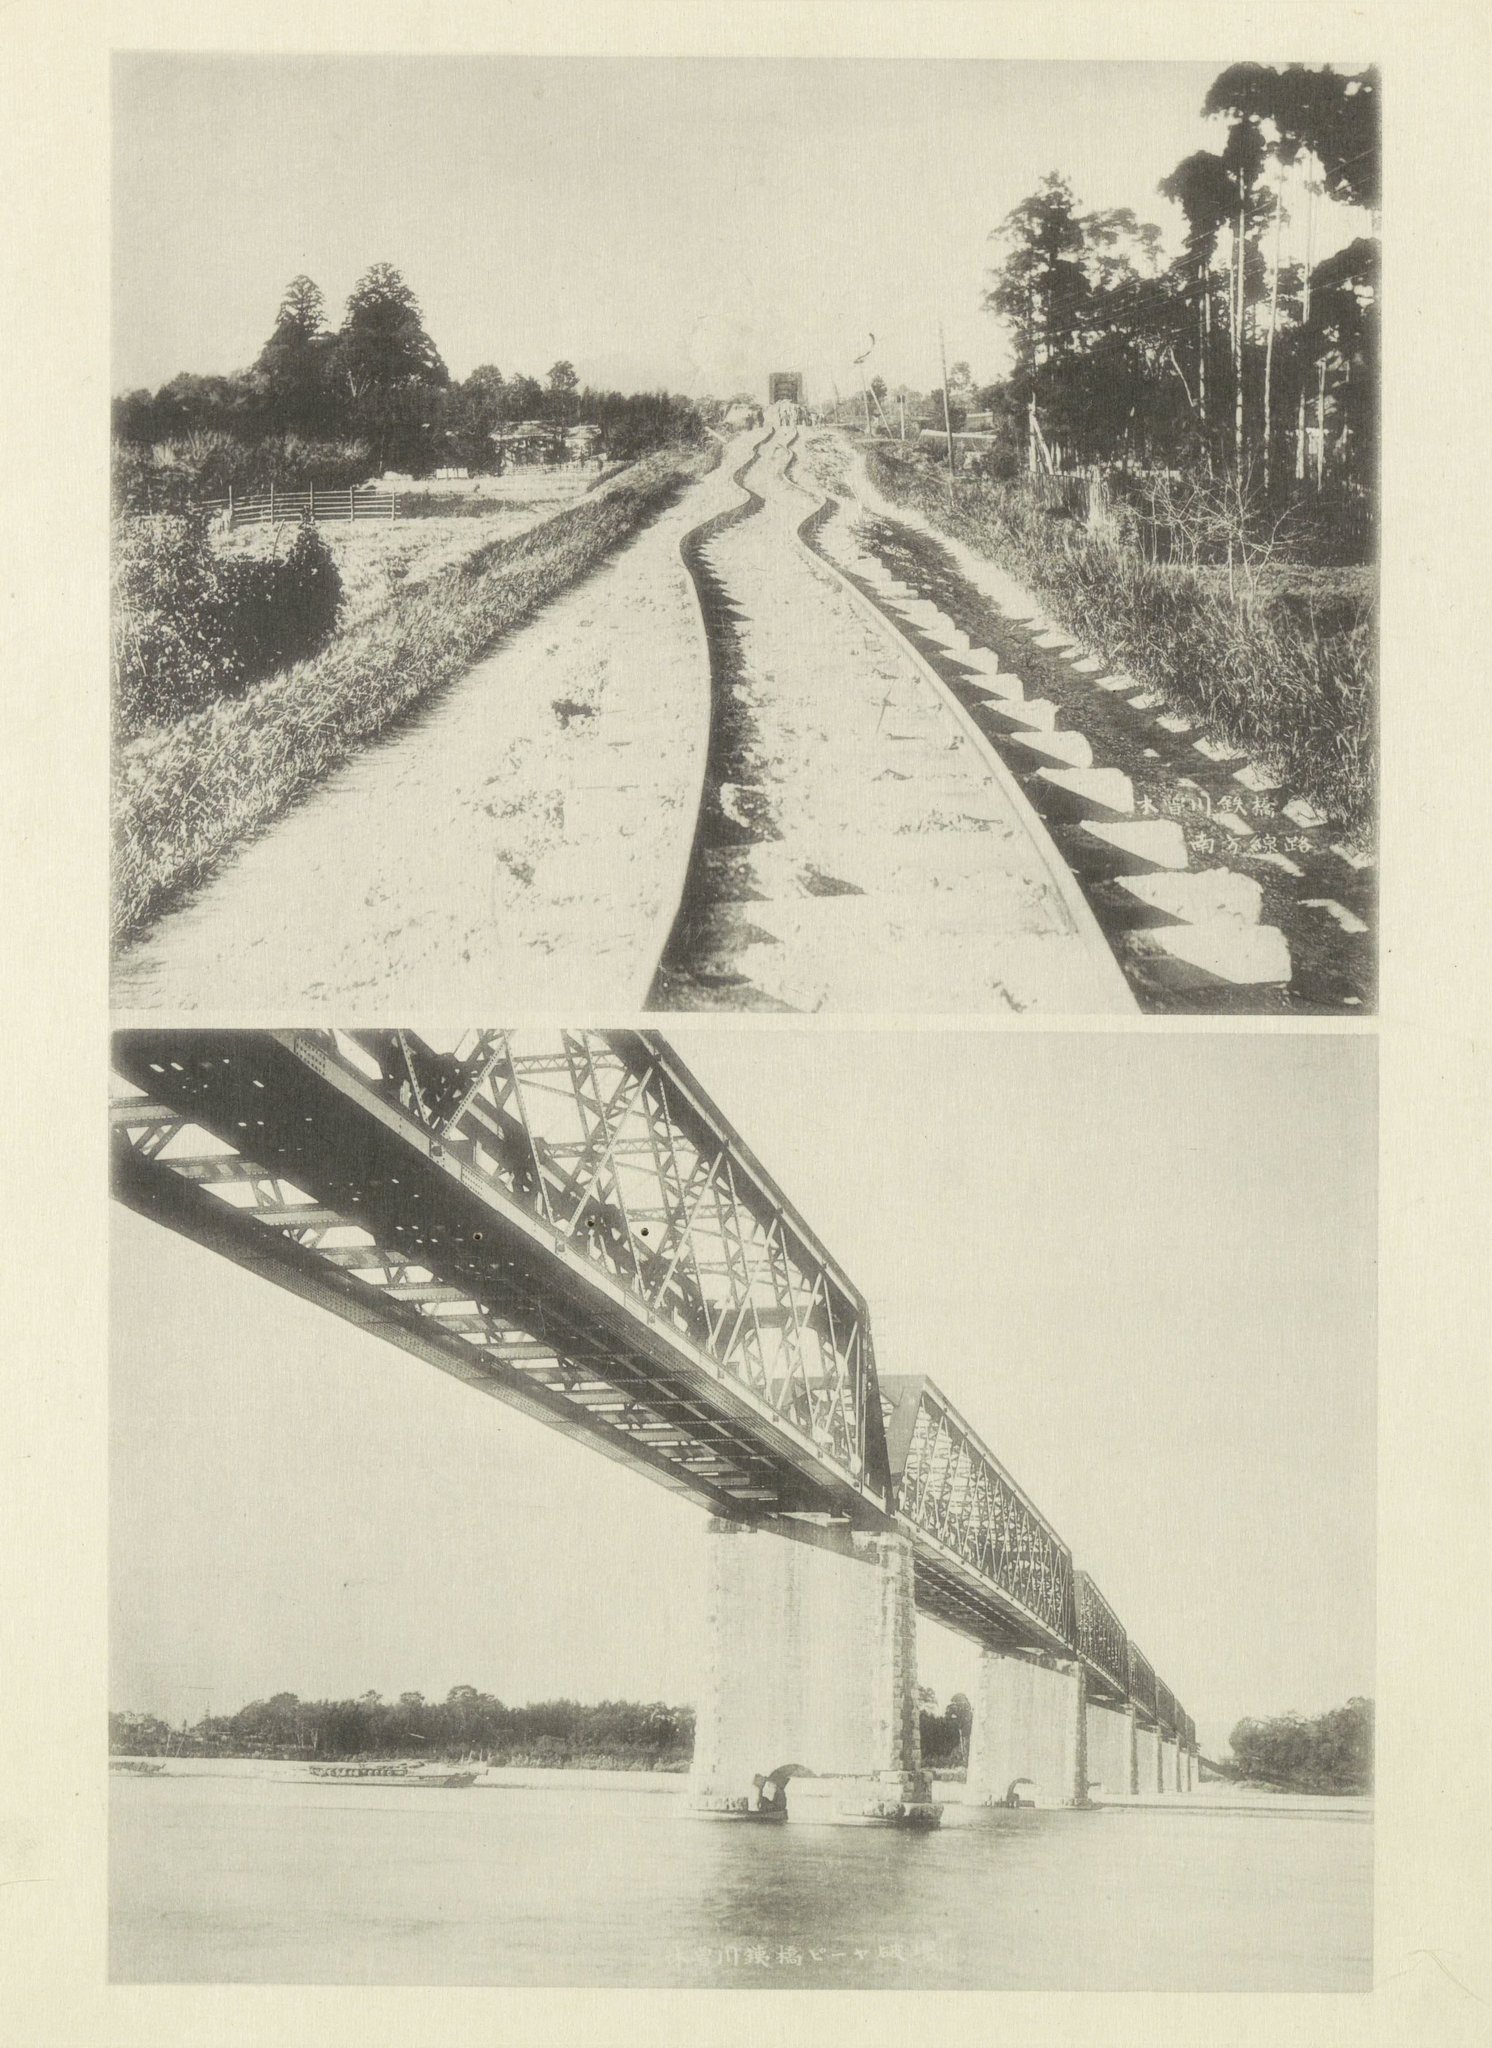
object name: page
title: Twee gezichten op de spoorweg in Japan na een aardbeving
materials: paper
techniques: photograph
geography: japan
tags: consequences of an earthquake, railway, tramway; rack railway, bridge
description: Boven een gedraaid spoor, onder een gezicht op de Kisogawa-spoorbrug.